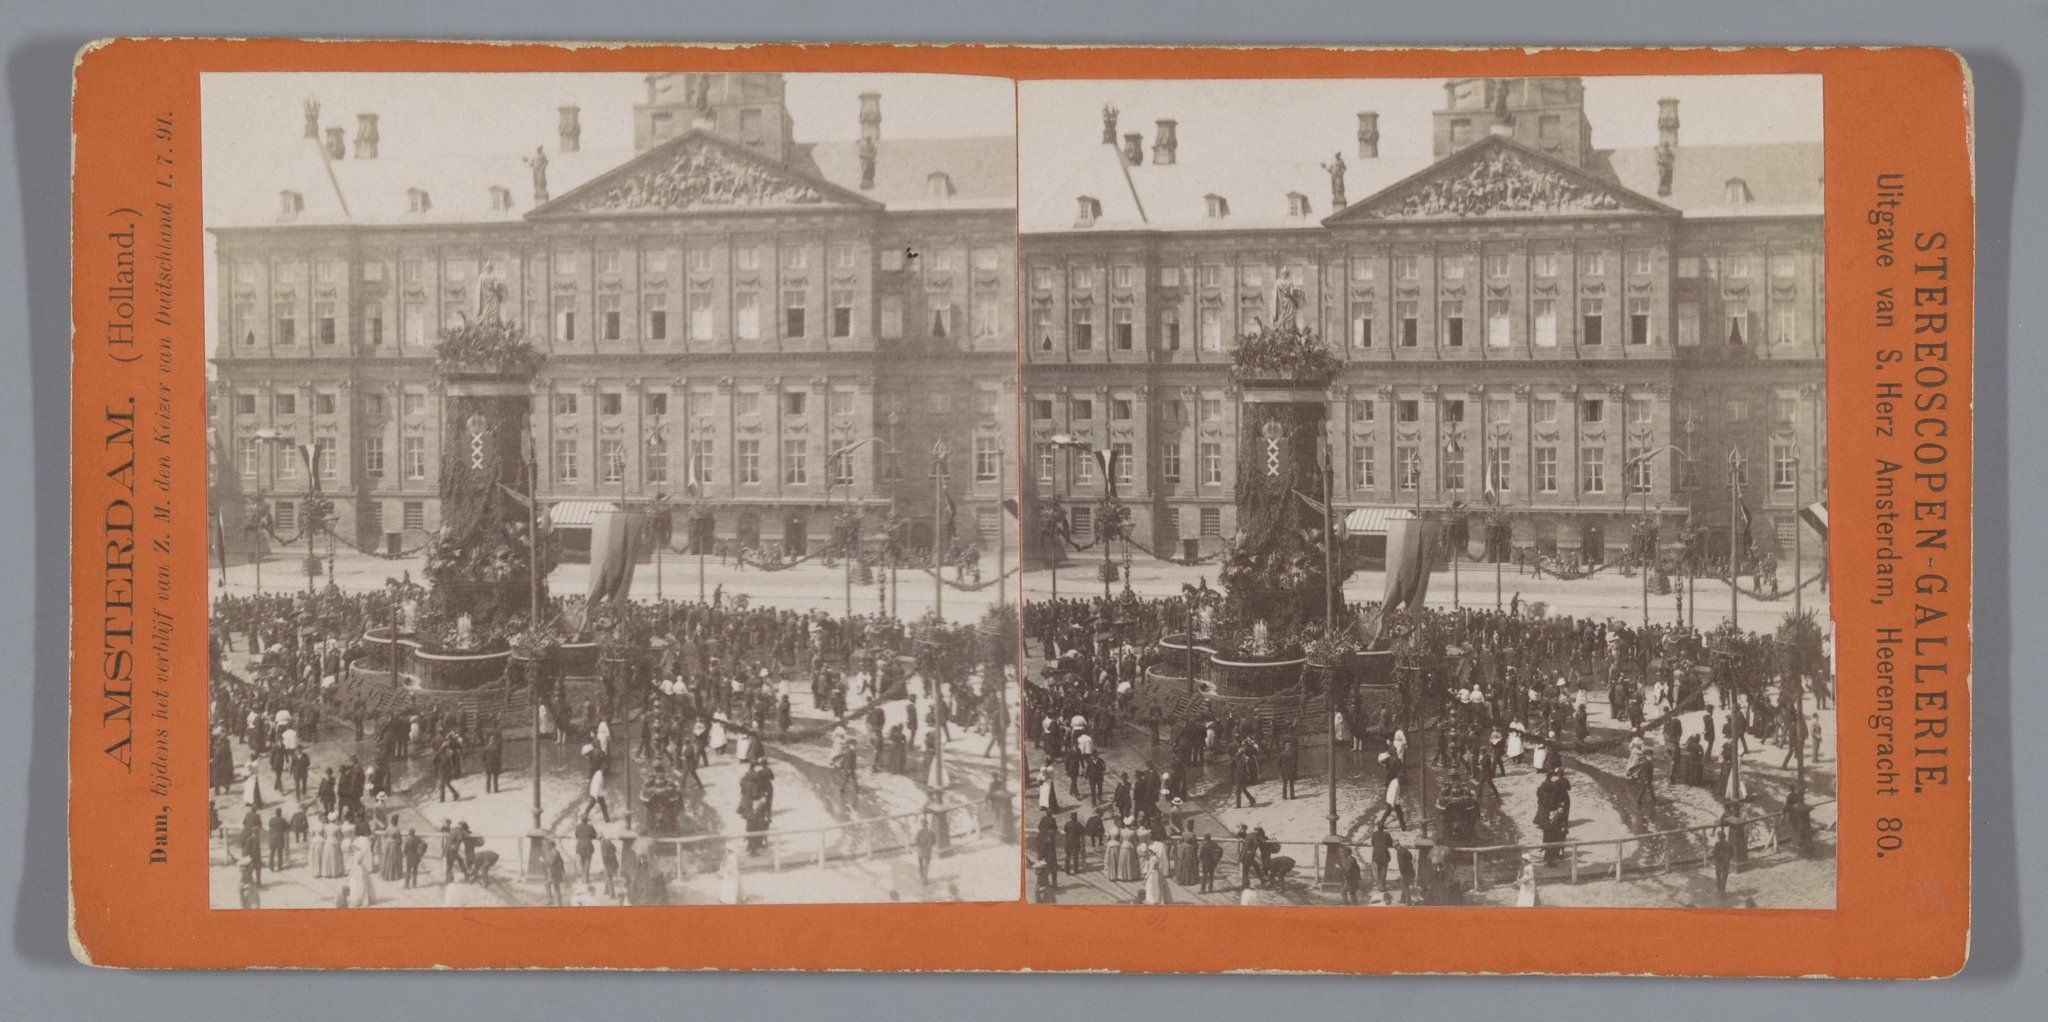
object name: stereograph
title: Stereoscopen-Gallerie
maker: sigmund löw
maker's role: publisher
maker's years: 1845-1920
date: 1891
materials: cardboard, paper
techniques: albumen print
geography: amsterdam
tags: square, place, circus, etc., palace, royal palace of amsterdam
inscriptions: inscription: ‘Paleis op den Dam Juli 1891, toen Wilhelm II daar was/ No 44’, address: ‘Heerengracht 80 & Heerenstraat 4’